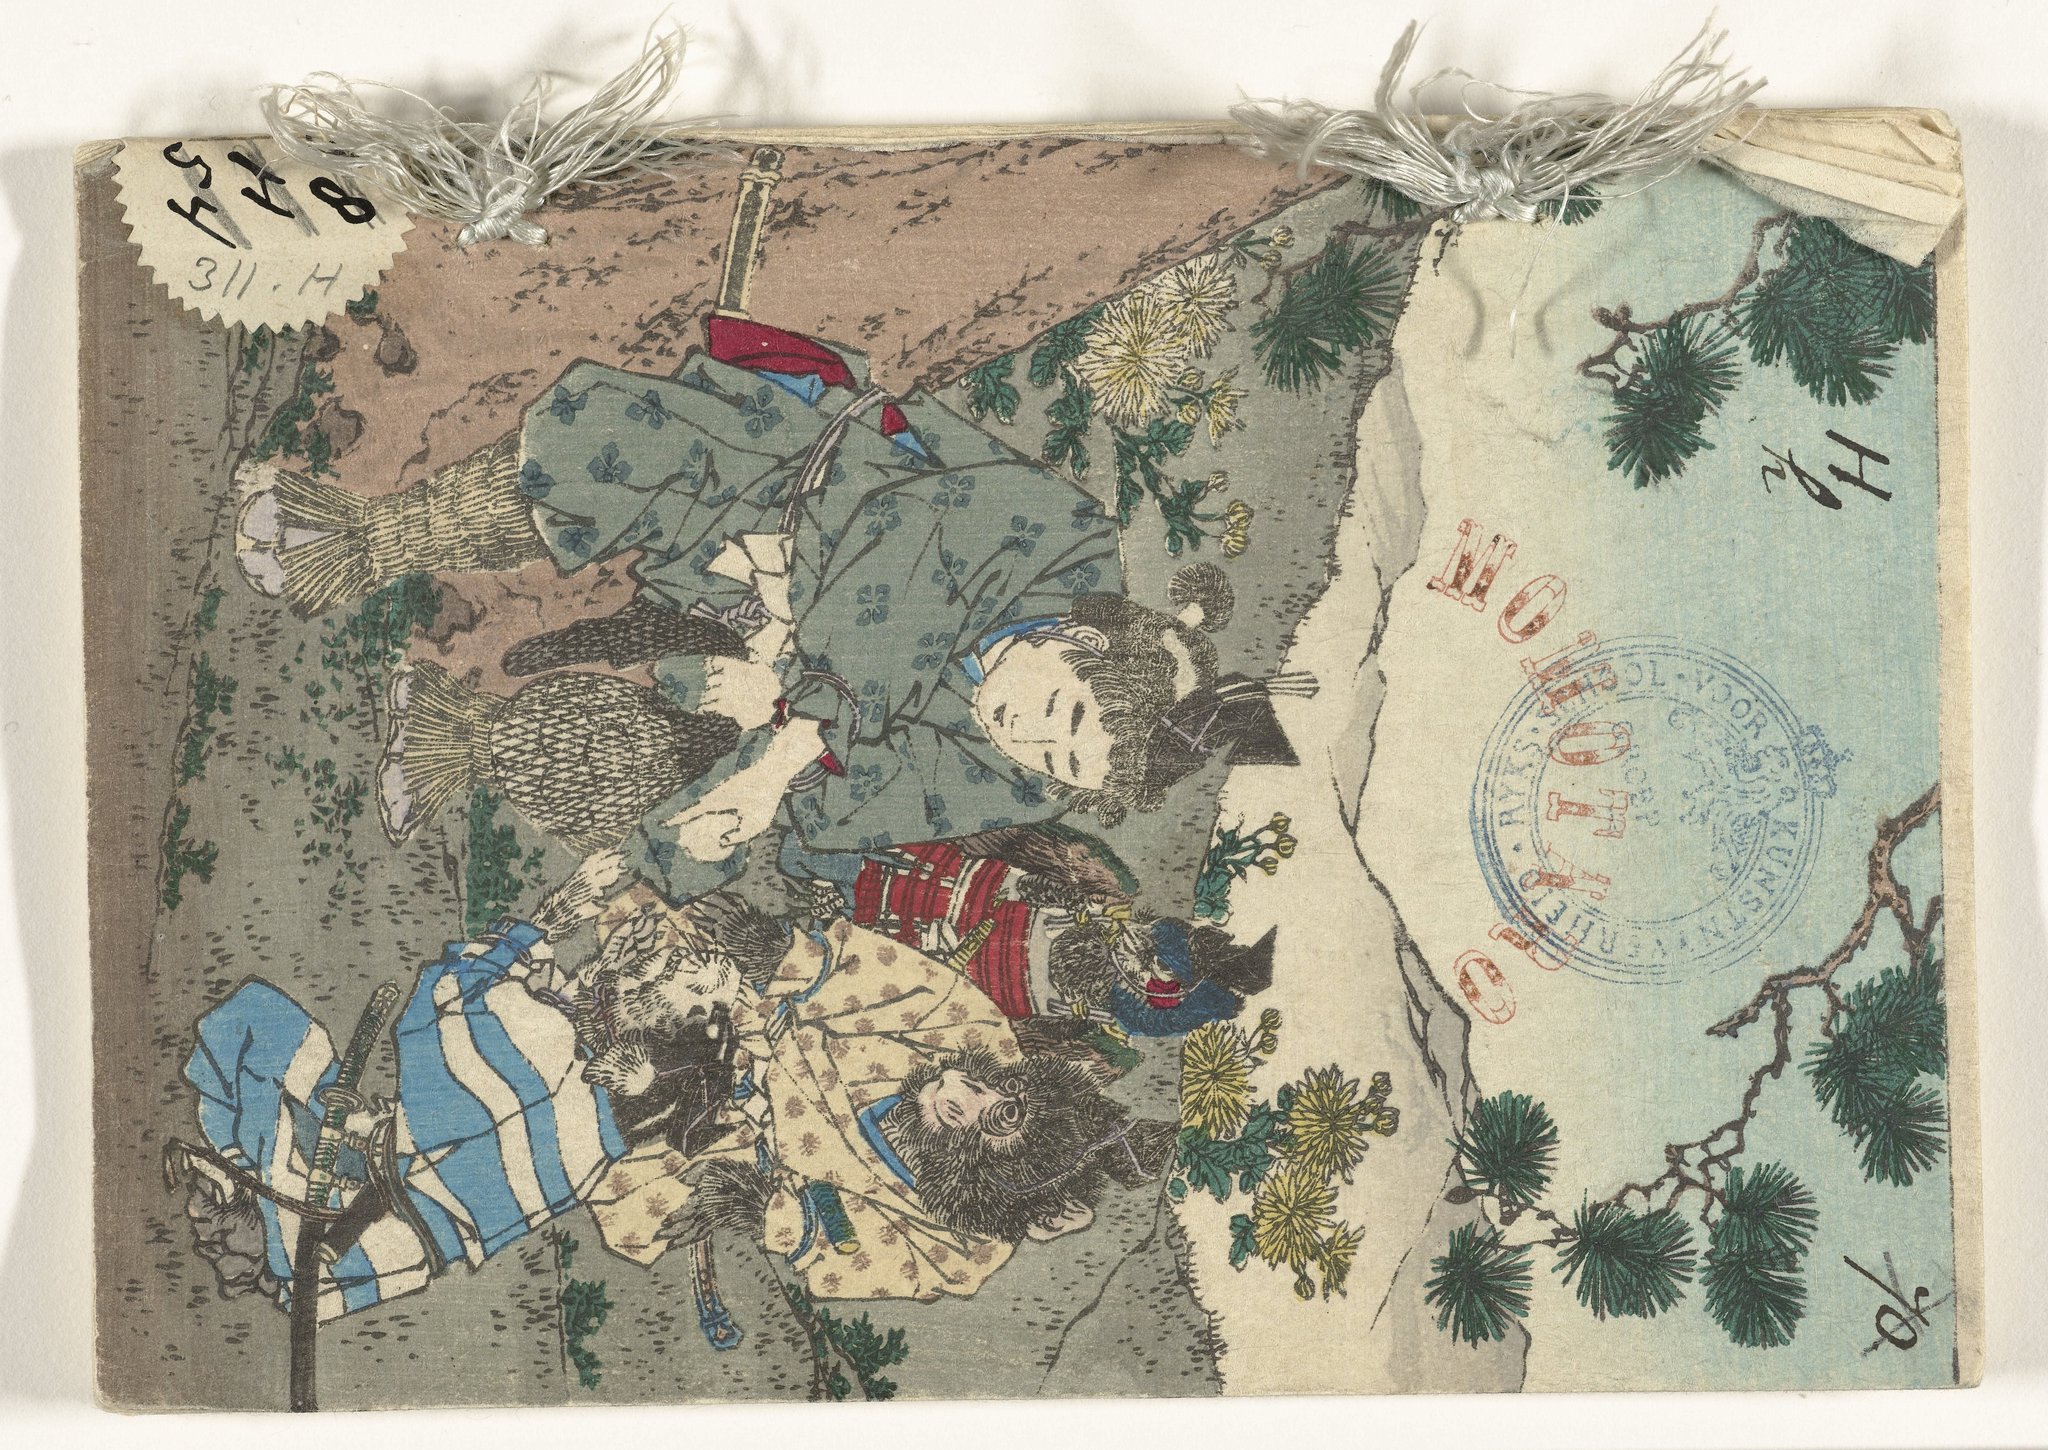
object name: book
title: Japanese fairy tale series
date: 1885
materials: paper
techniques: woodcut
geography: tokyo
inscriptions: collector's mark: ‘Rijksschool voor kunstnijverheid’ Lugt 3937